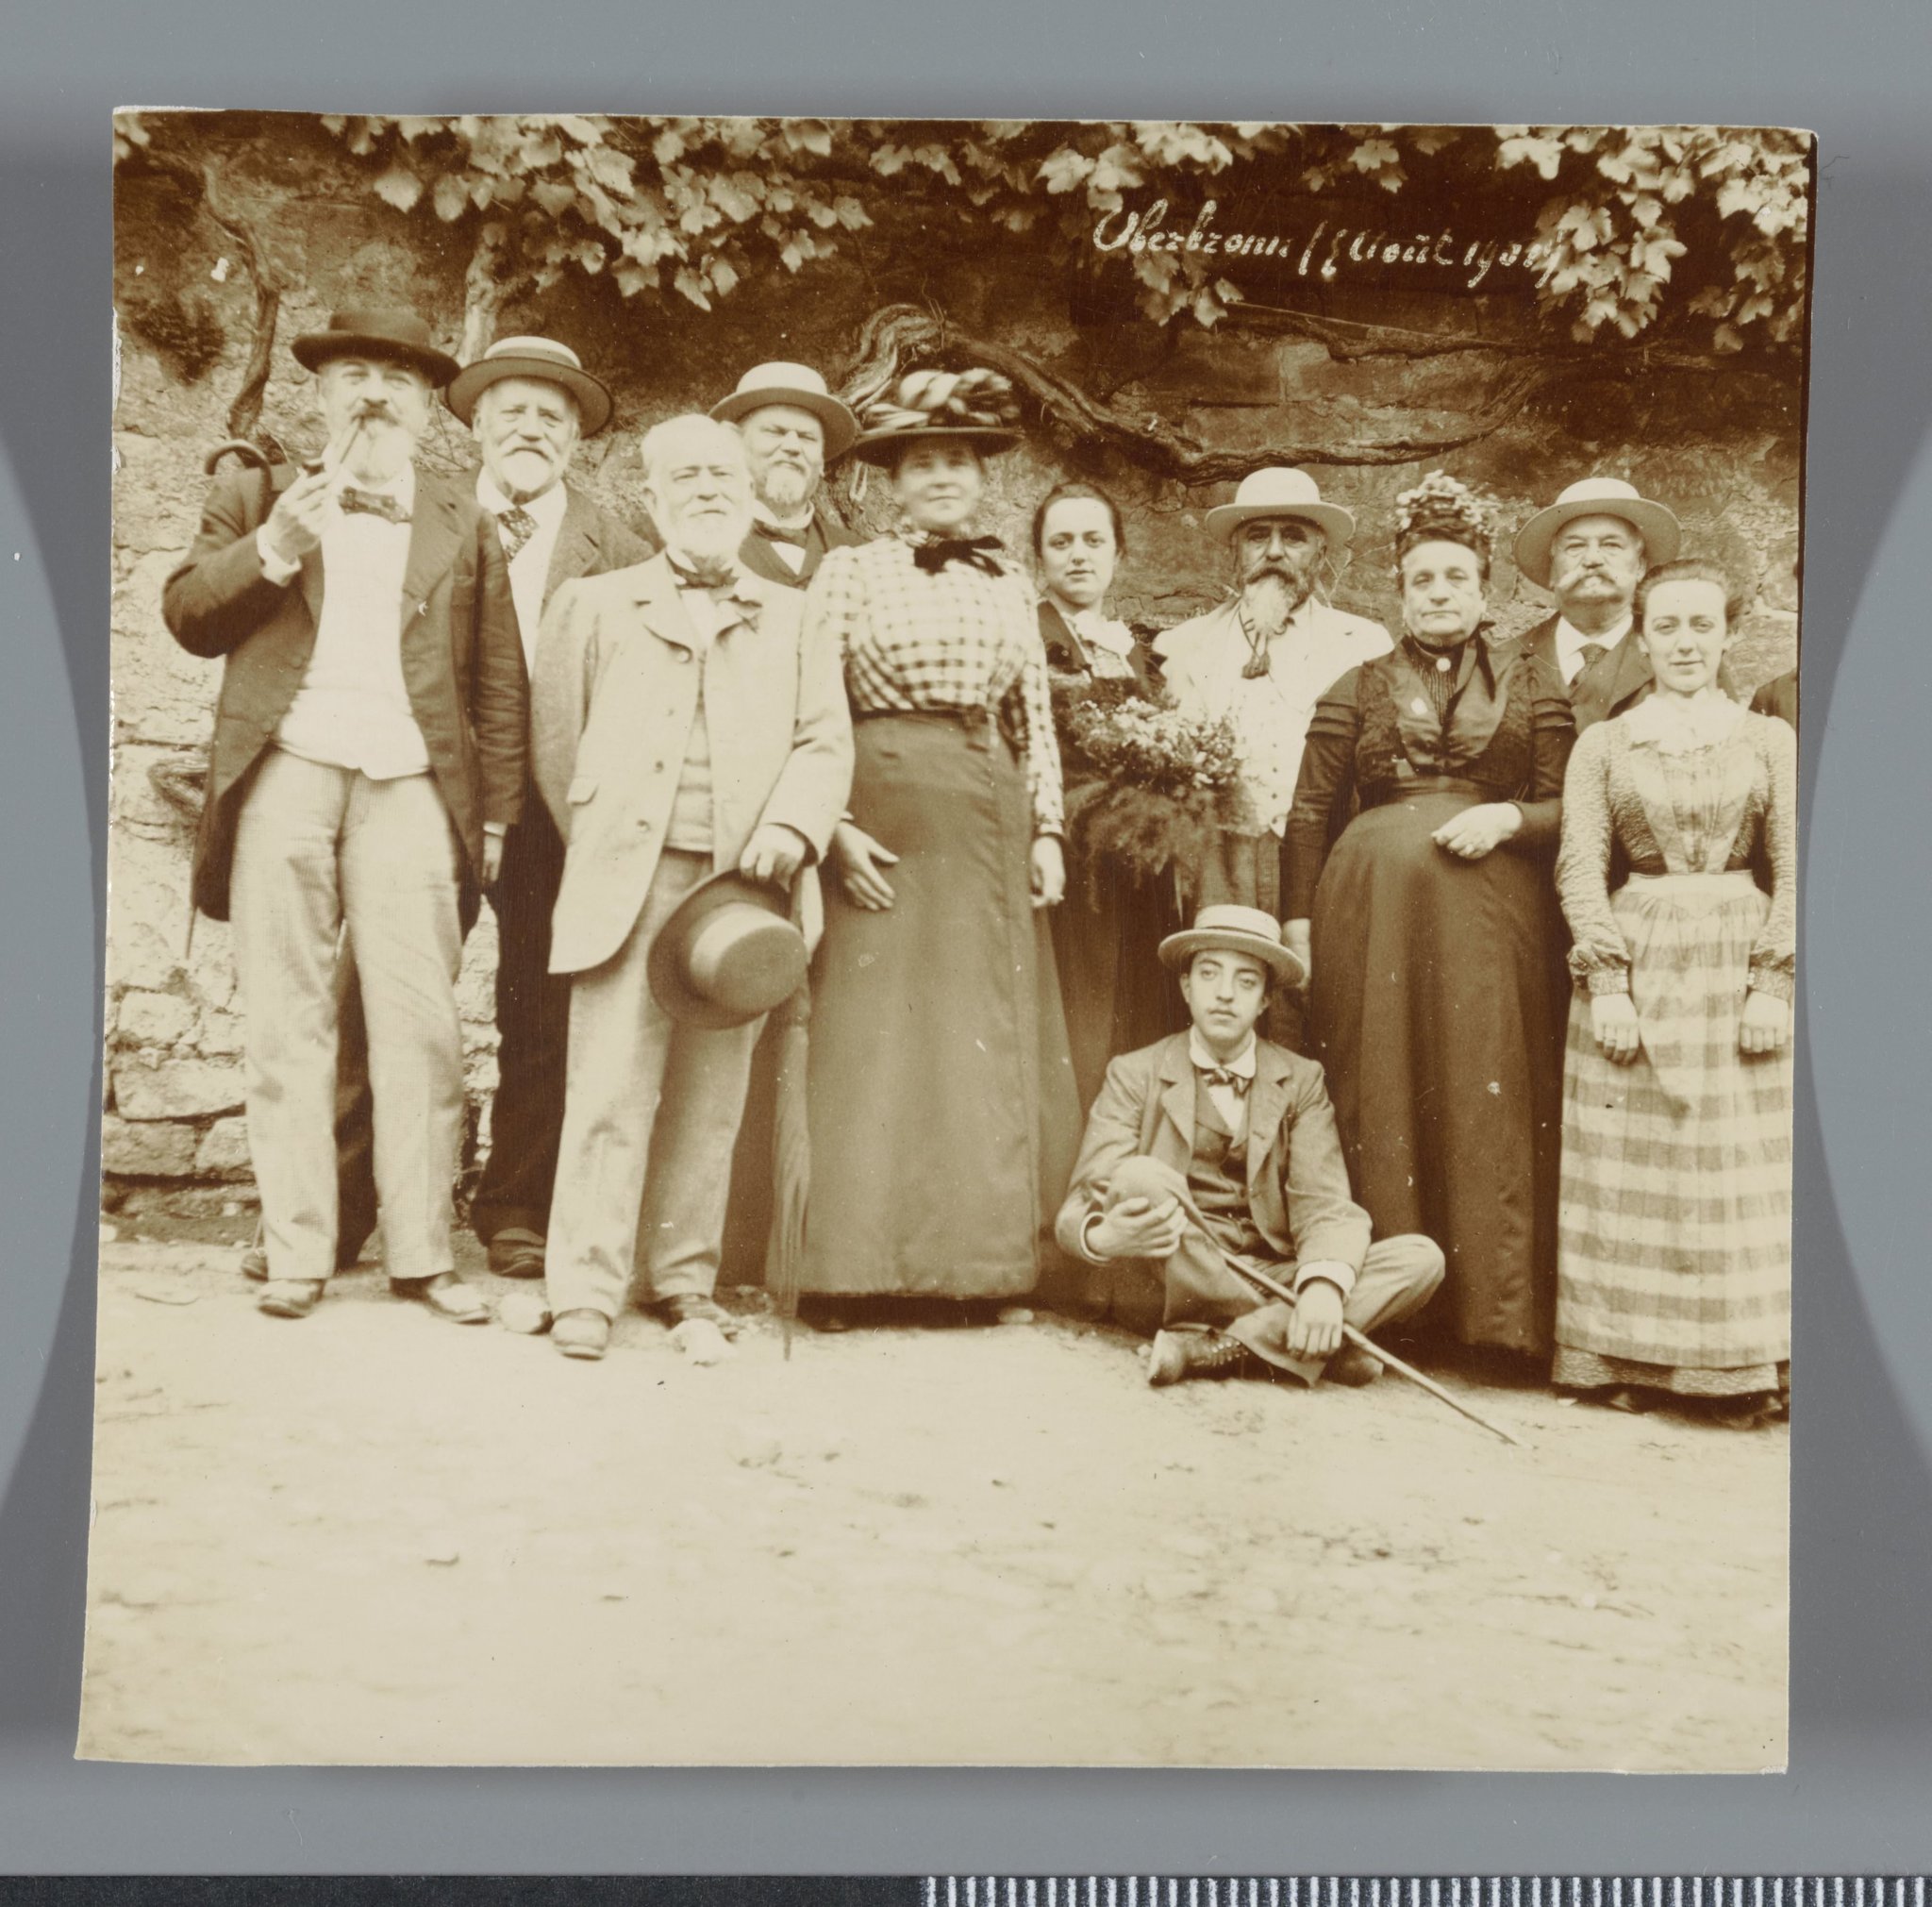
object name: photograph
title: Groepsportret van zeven mannen en vier vrouwen, Oberbronn (Bas-Rhin), Frankrijk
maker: Anonymous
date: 1902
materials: paper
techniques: gelatin silver print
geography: france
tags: public road in village (+ city(-scape) with figures, staffage), france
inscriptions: annotation: ‘Oberbronn 5 Août 1902 [?]’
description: Groepsportret van zeven mannen en vier vrouwen, Oberbronn (Bas-Rhin), Frankrijk.